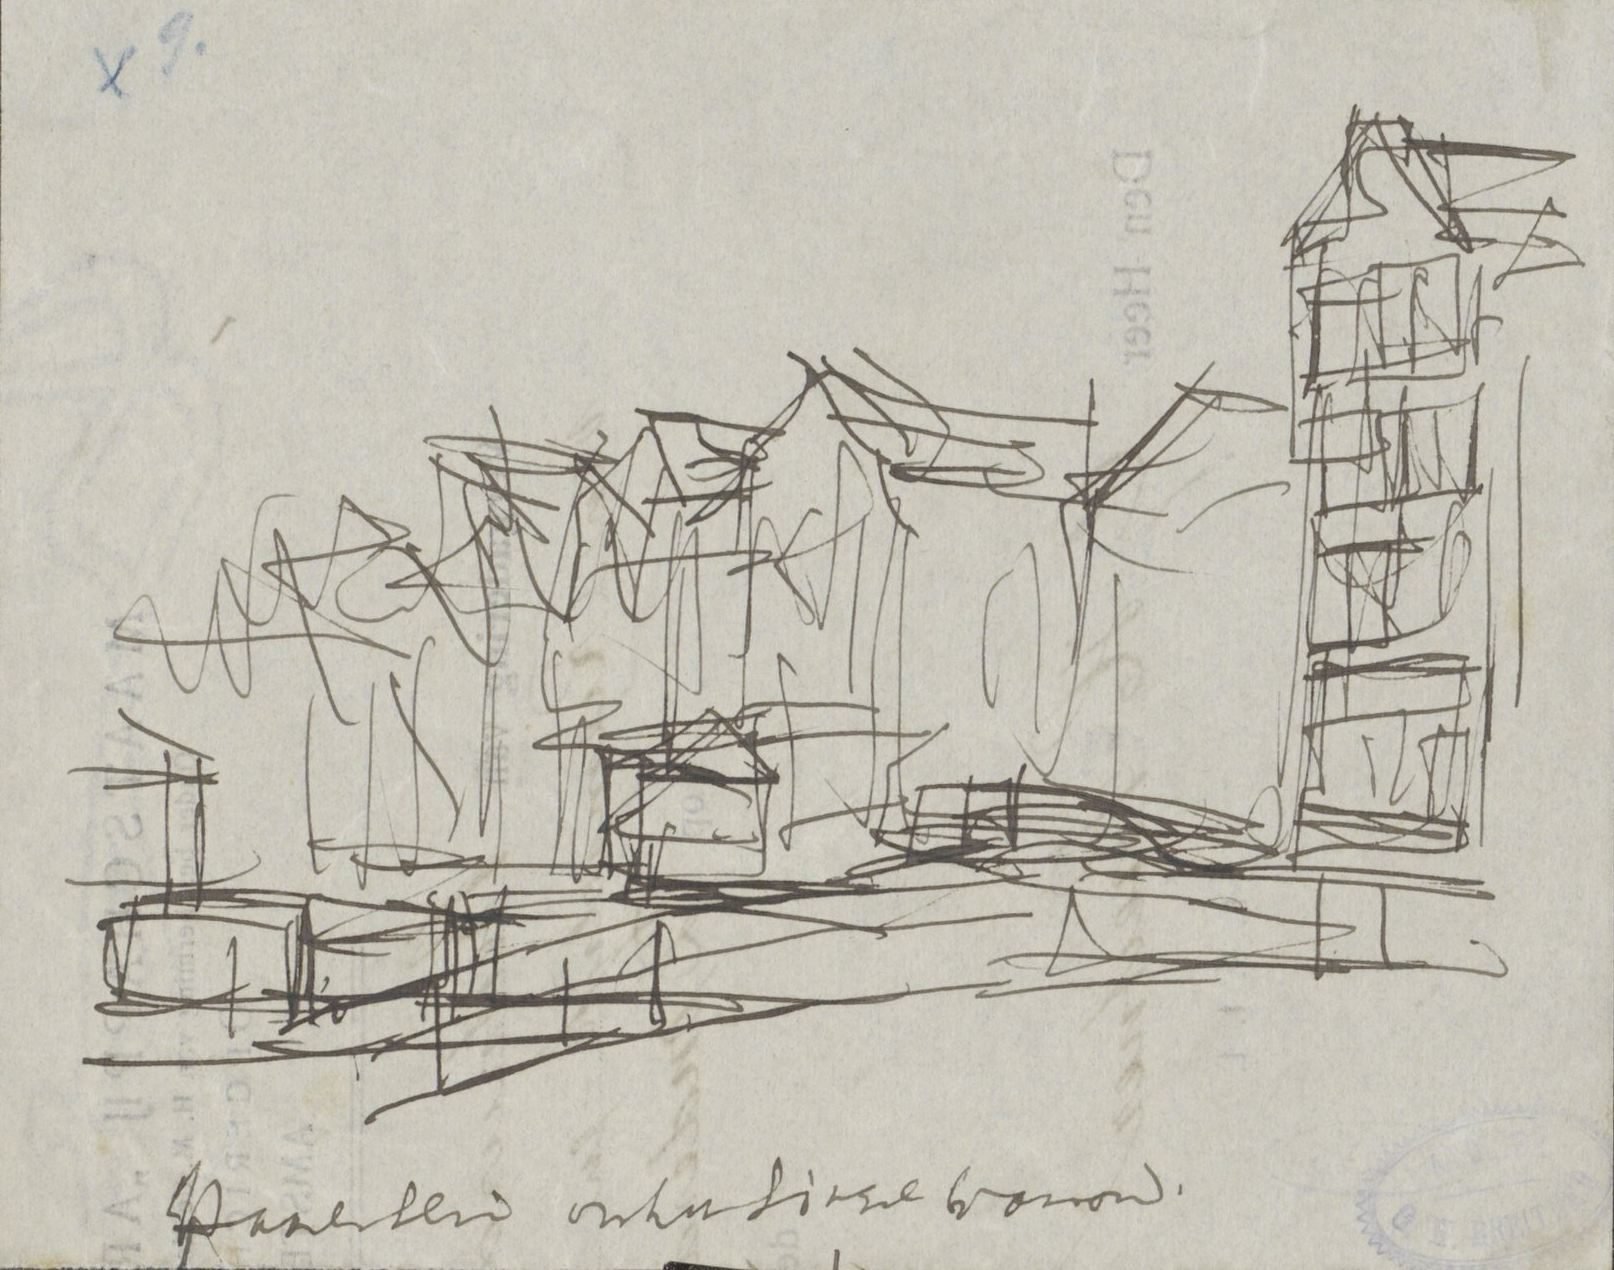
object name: invitation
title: Gezicht op het Singel te Amsterdam, mogelijk met de Haarlemmersluis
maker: george hendrik breitner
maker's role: draughtsman, painter, print maker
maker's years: 1857-1923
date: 1894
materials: paper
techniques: pen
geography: amsterdam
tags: bridge in city across river, canal, etc.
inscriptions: collector's mark: Lugt 2228, annotation: ‘Haarlem[?] op het Singel bij avond’, annotation: ‘[Briefhoofd van Arti et Amicitiae]/ Vergadering van Bestuur/ van Riemsdijk en/ op Donderdag/ Den Heer G.H. Breitner/ s.s.t.t.’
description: Verso een uitnodiging voor een vergadering van kunstenaarsvereniging Arti et Amicitiae.